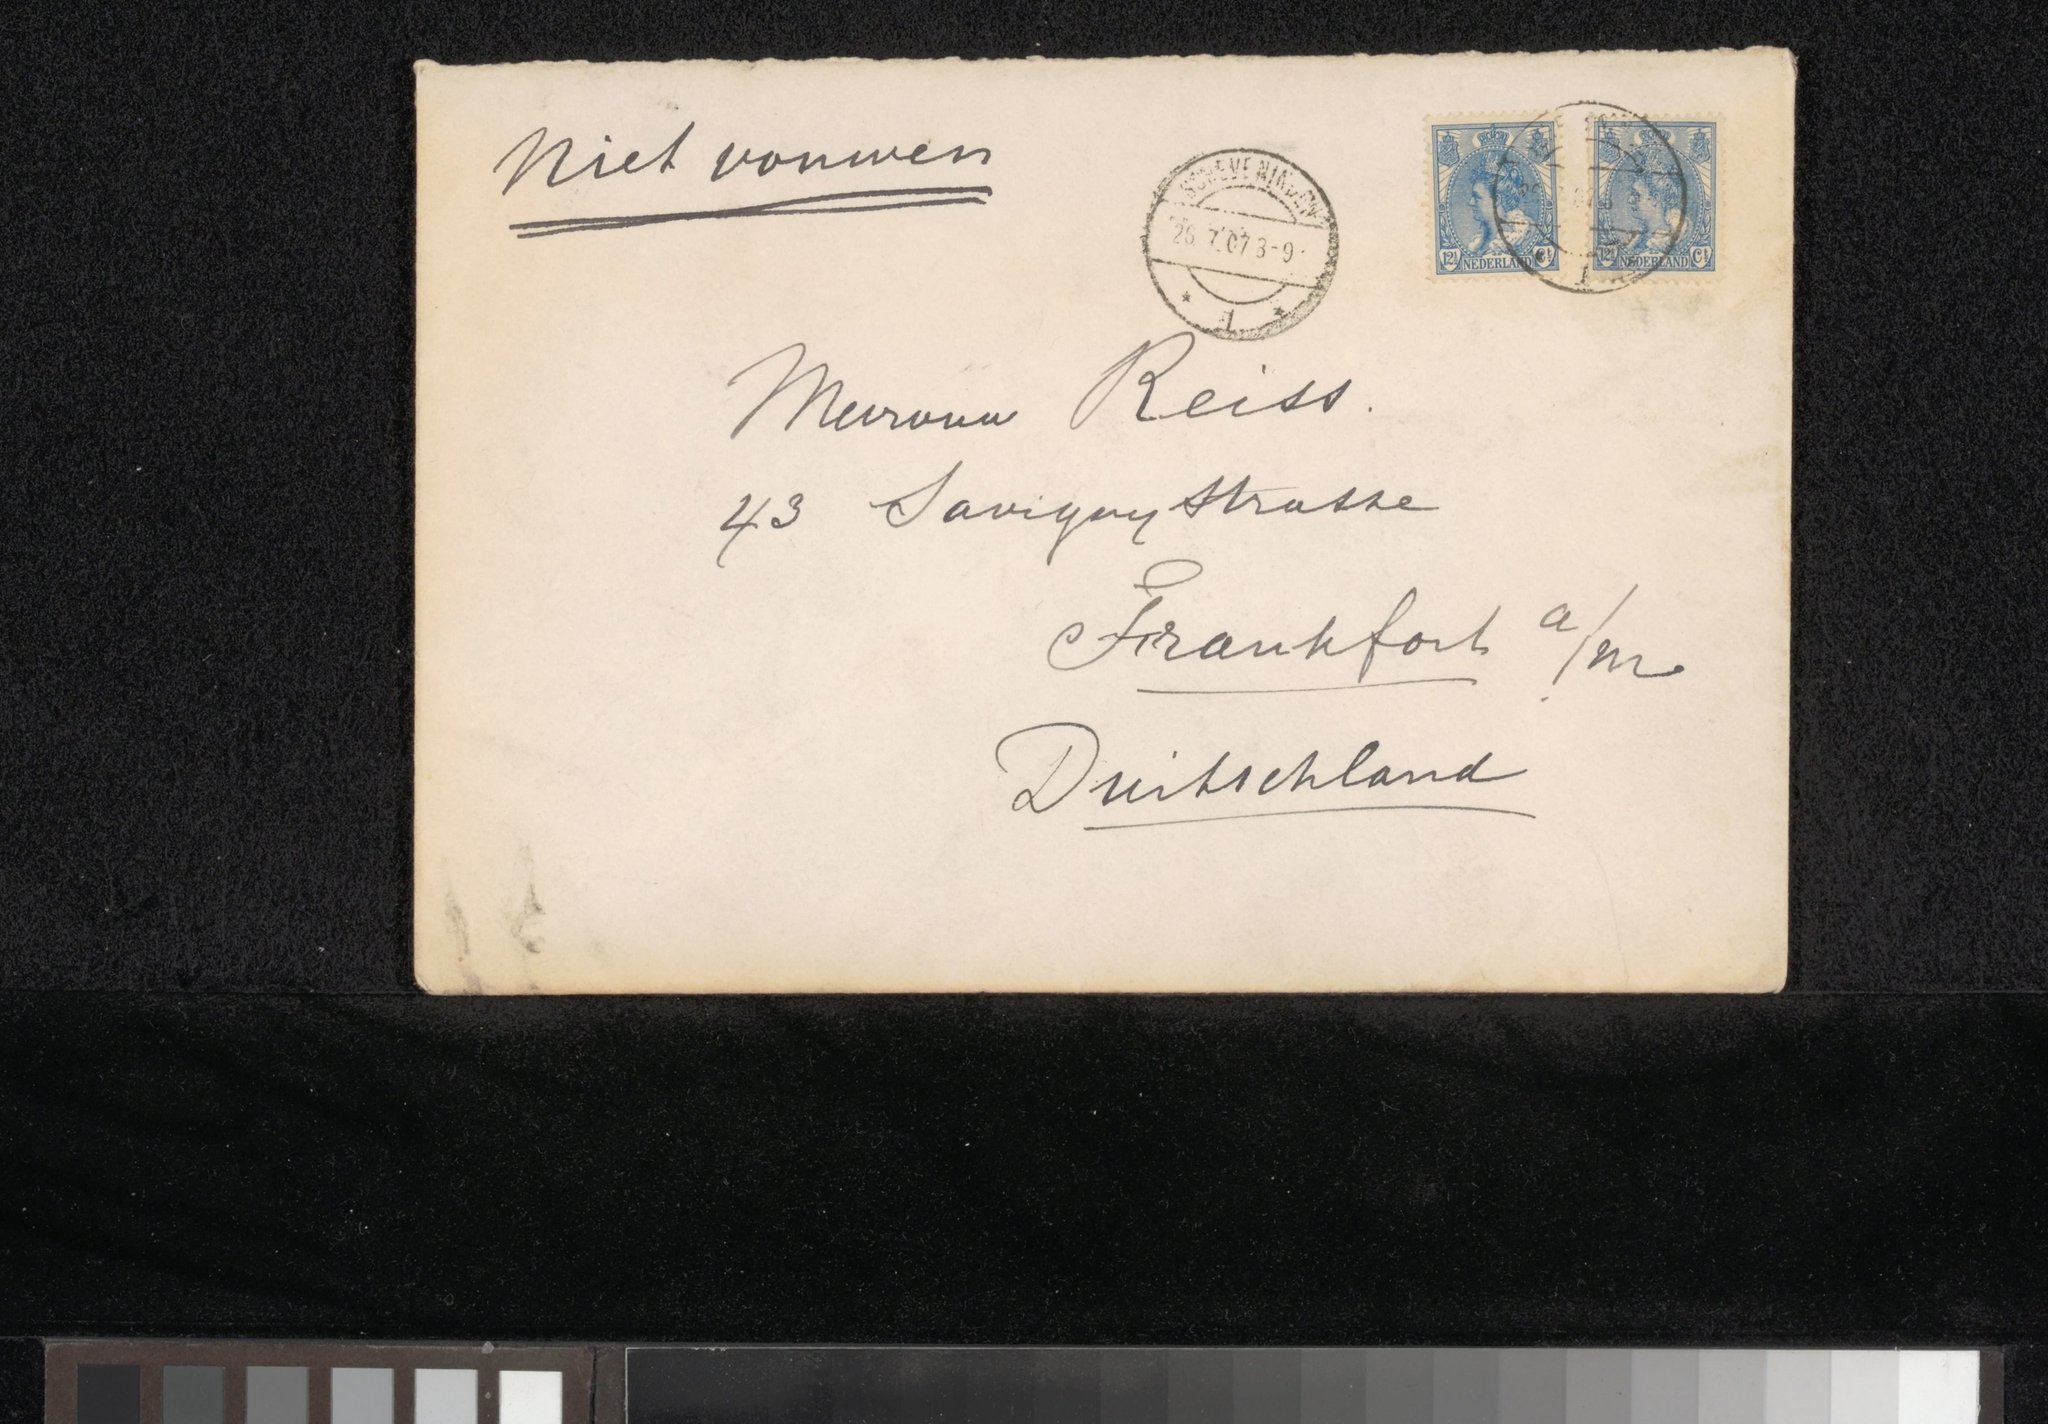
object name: envelope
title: Envelop aan mevrouw Reiss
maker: hendrik willem mesdag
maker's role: draughtsman, painter, print maker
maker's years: 1831-1915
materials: ink, paper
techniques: pen, writing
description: Tekening RP-D-1981-17A is verstuurd in deze envelop.